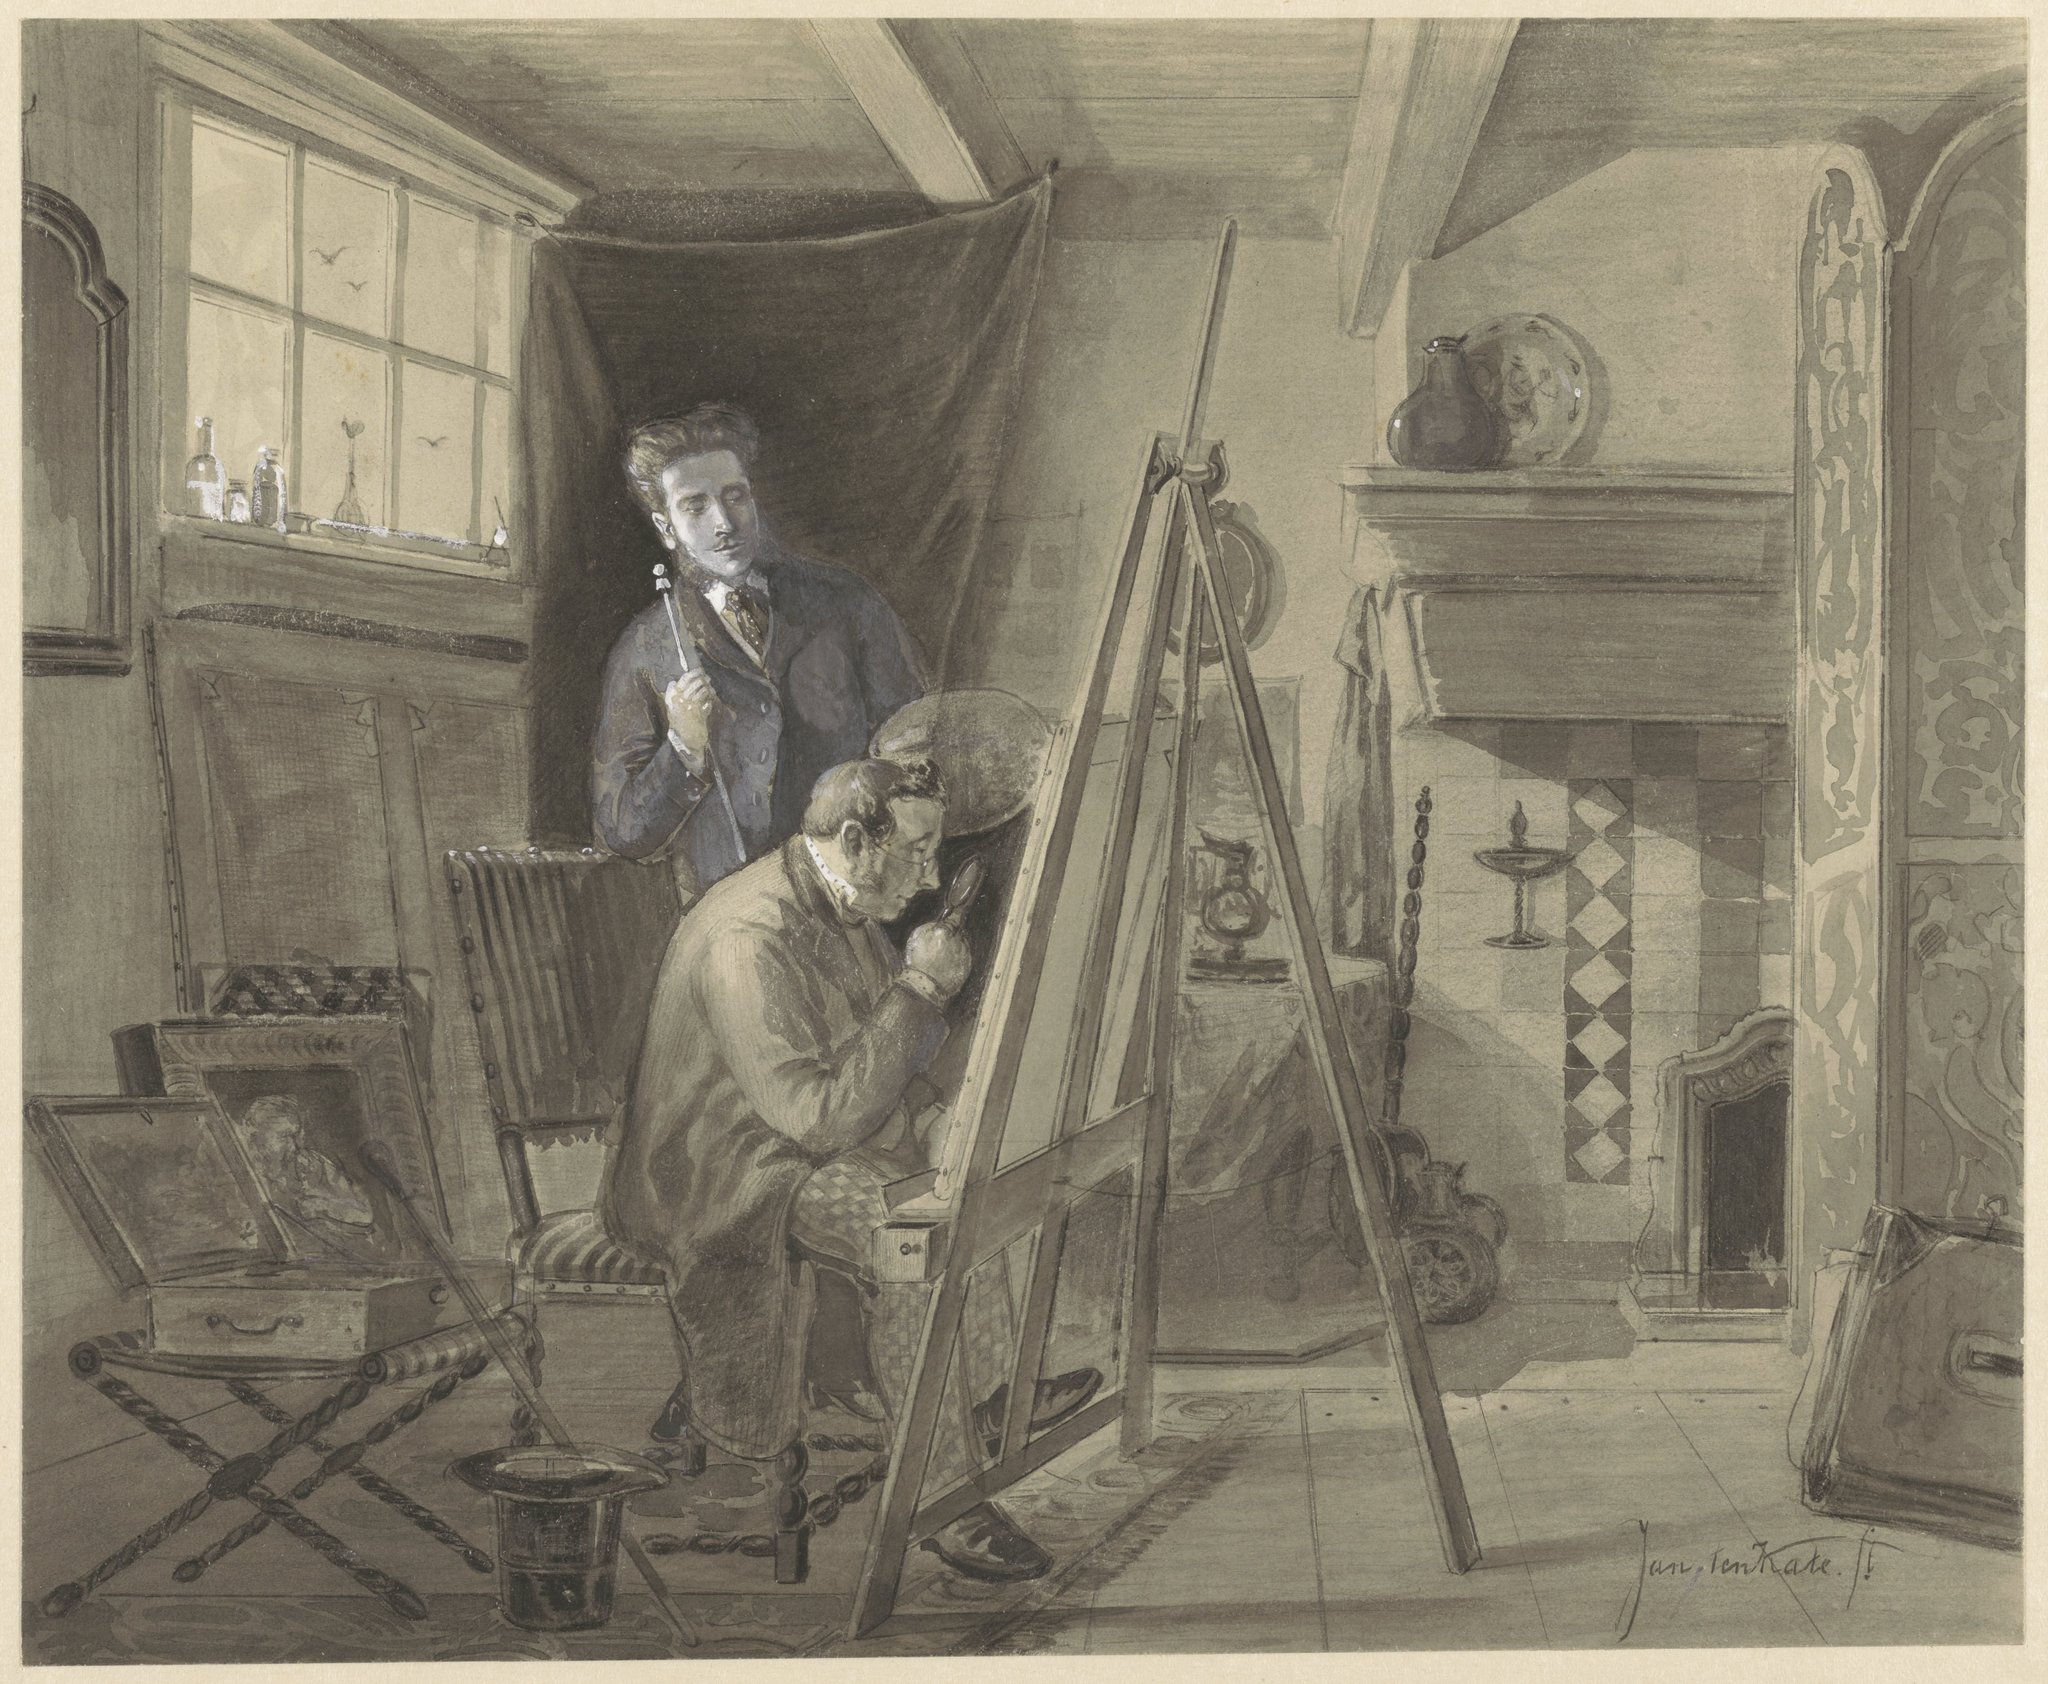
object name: drawing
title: Zelfportret van Johannes Marius van Kate, staande in zijn atelier met een bezoeker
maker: johannes marius ten kate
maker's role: draughtsman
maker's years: 1859-1896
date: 1869-1896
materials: chalk, paint, paper, pencil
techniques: brush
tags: amsterdam, the hague, draughtsman, johannes marius ten kate, portrait, self-portrait of painter (+ in workshop or studio), historical persons, portrait, self-portrait of artist, portrait, self-portrait of draughtsman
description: Zelfportret van de schilder en tekenaar Johannes Marius van Kate (Jan ten Kate), staande in zijn atelier met een bezoeker.